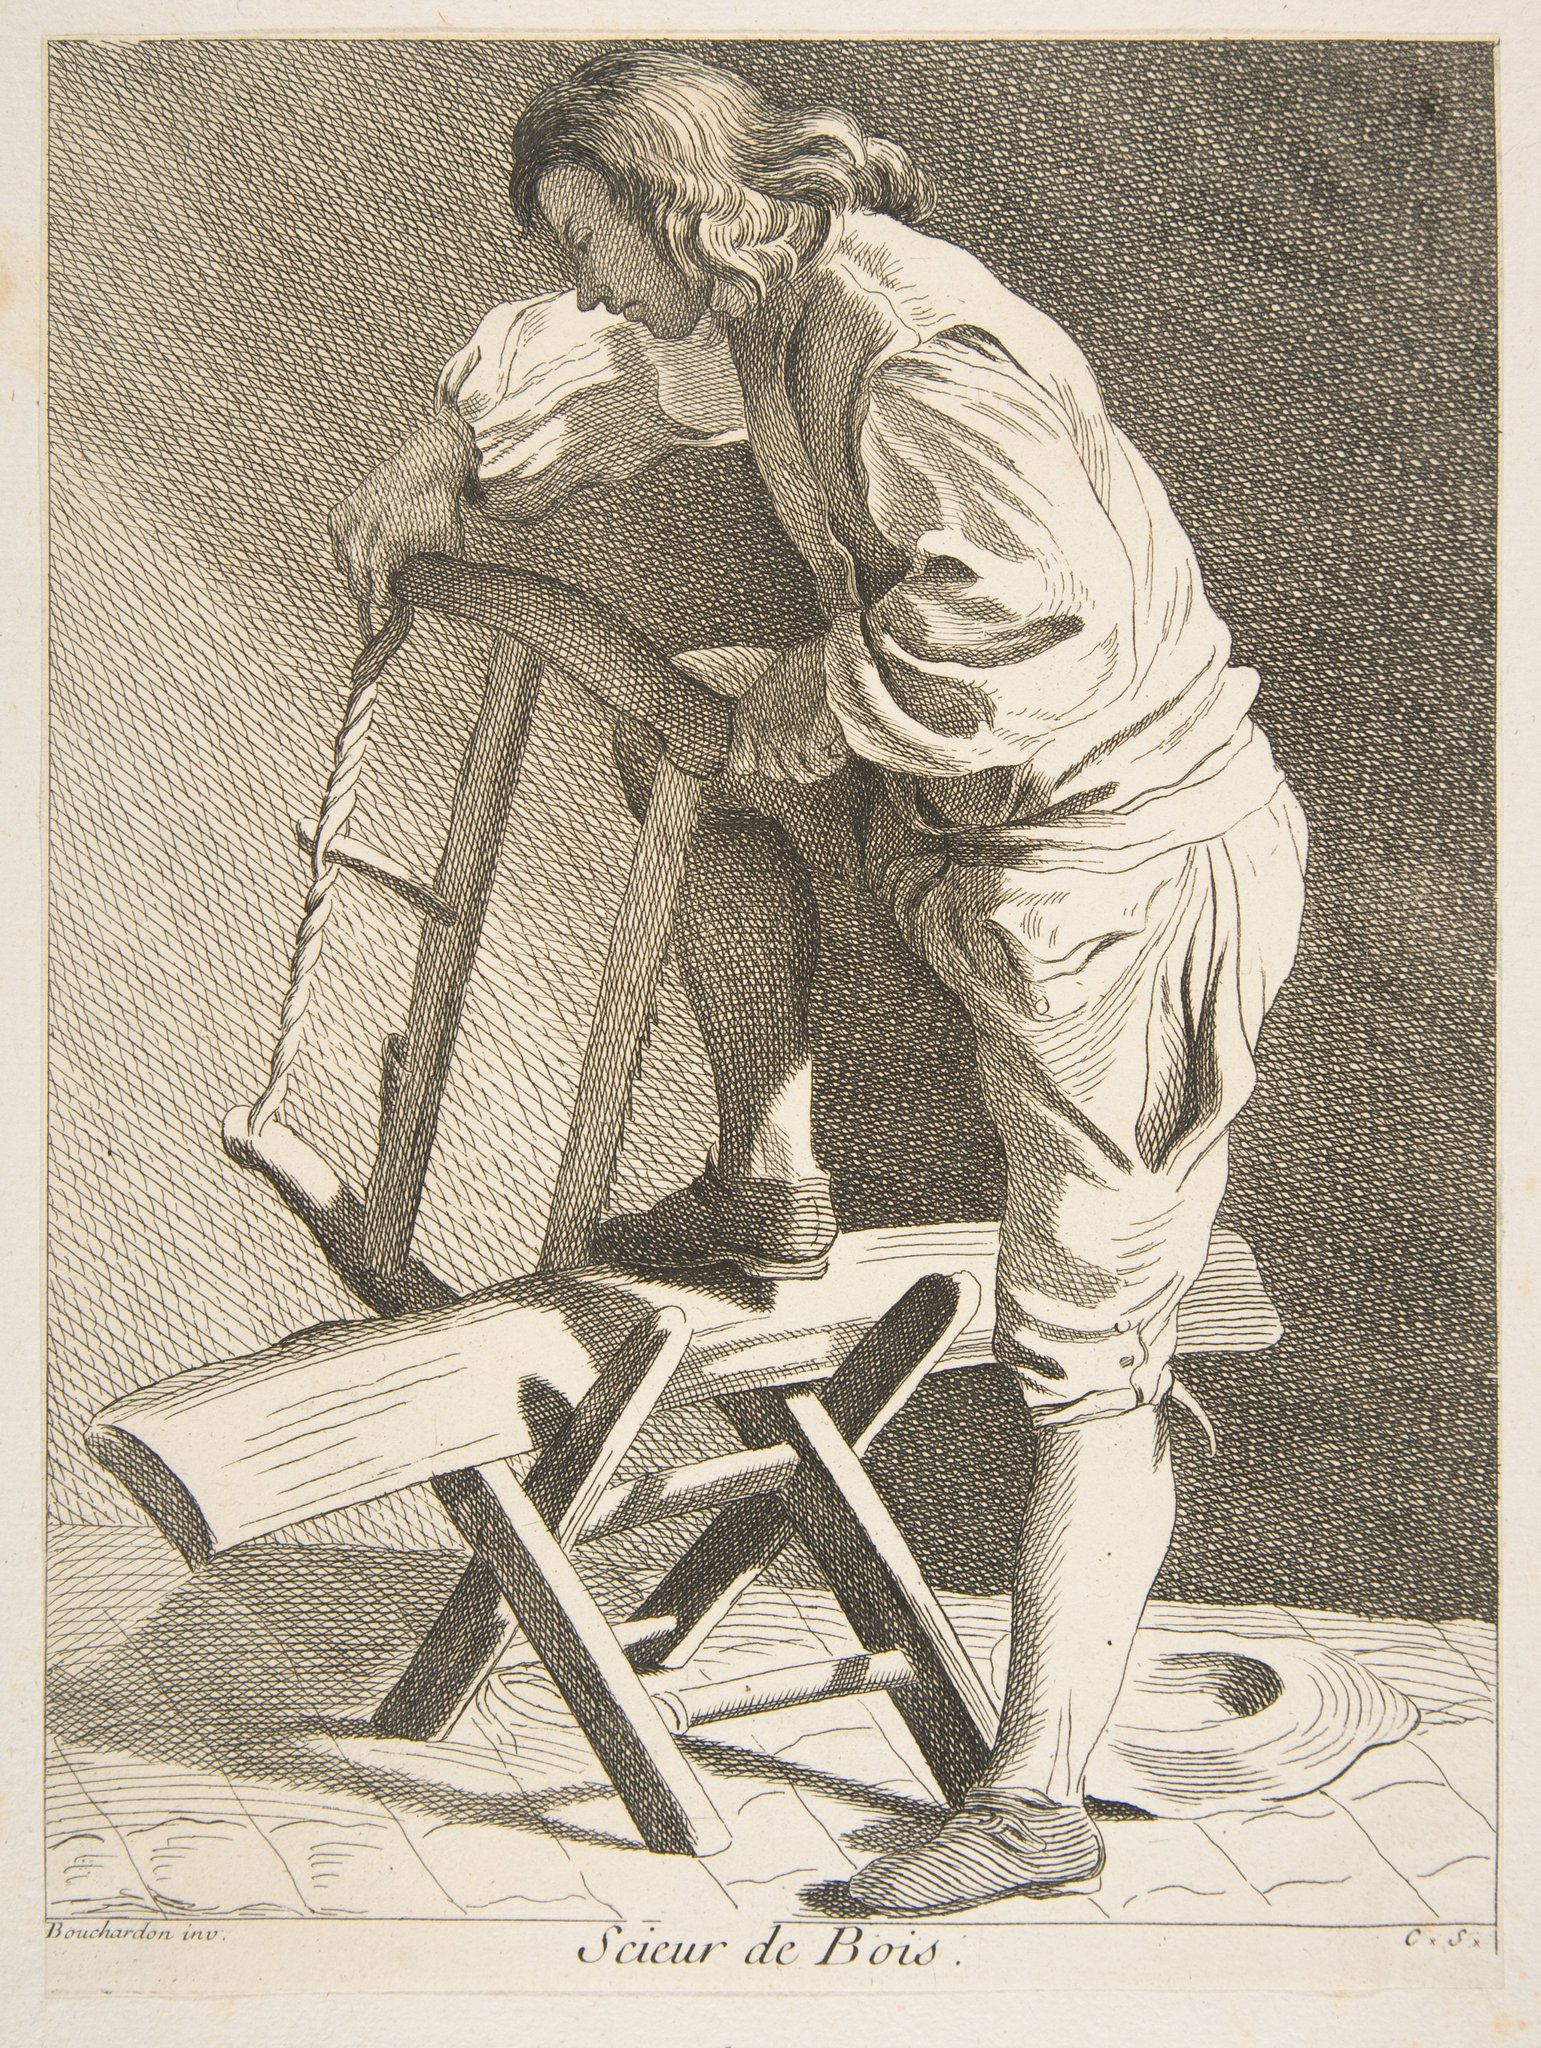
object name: print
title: Wood Cutter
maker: anne claude philippe de tubières, comte de caylus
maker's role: artist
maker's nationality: french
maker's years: 1692-1765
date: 1742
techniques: engraving, etching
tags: men,tools